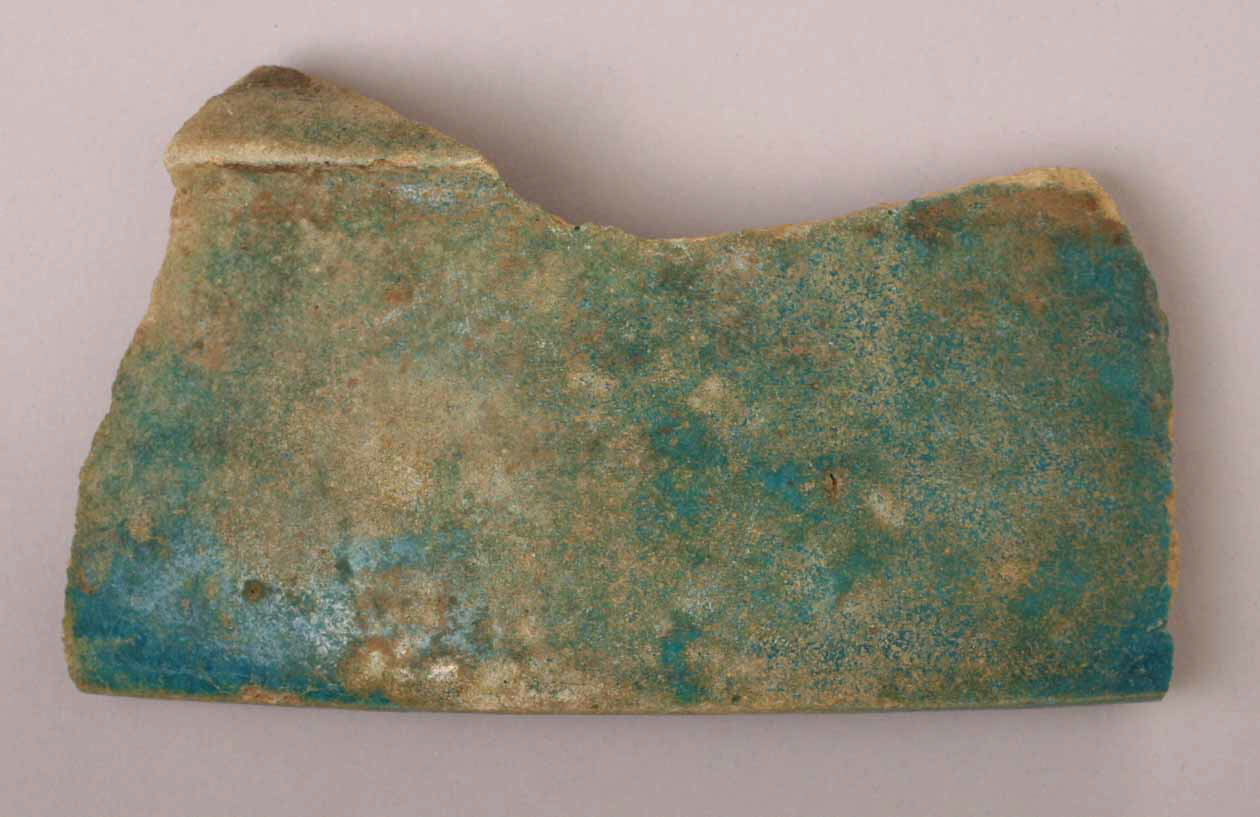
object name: fragment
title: Ceramic Fragment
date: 201-800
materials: earthenware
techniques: glazing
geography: iraq